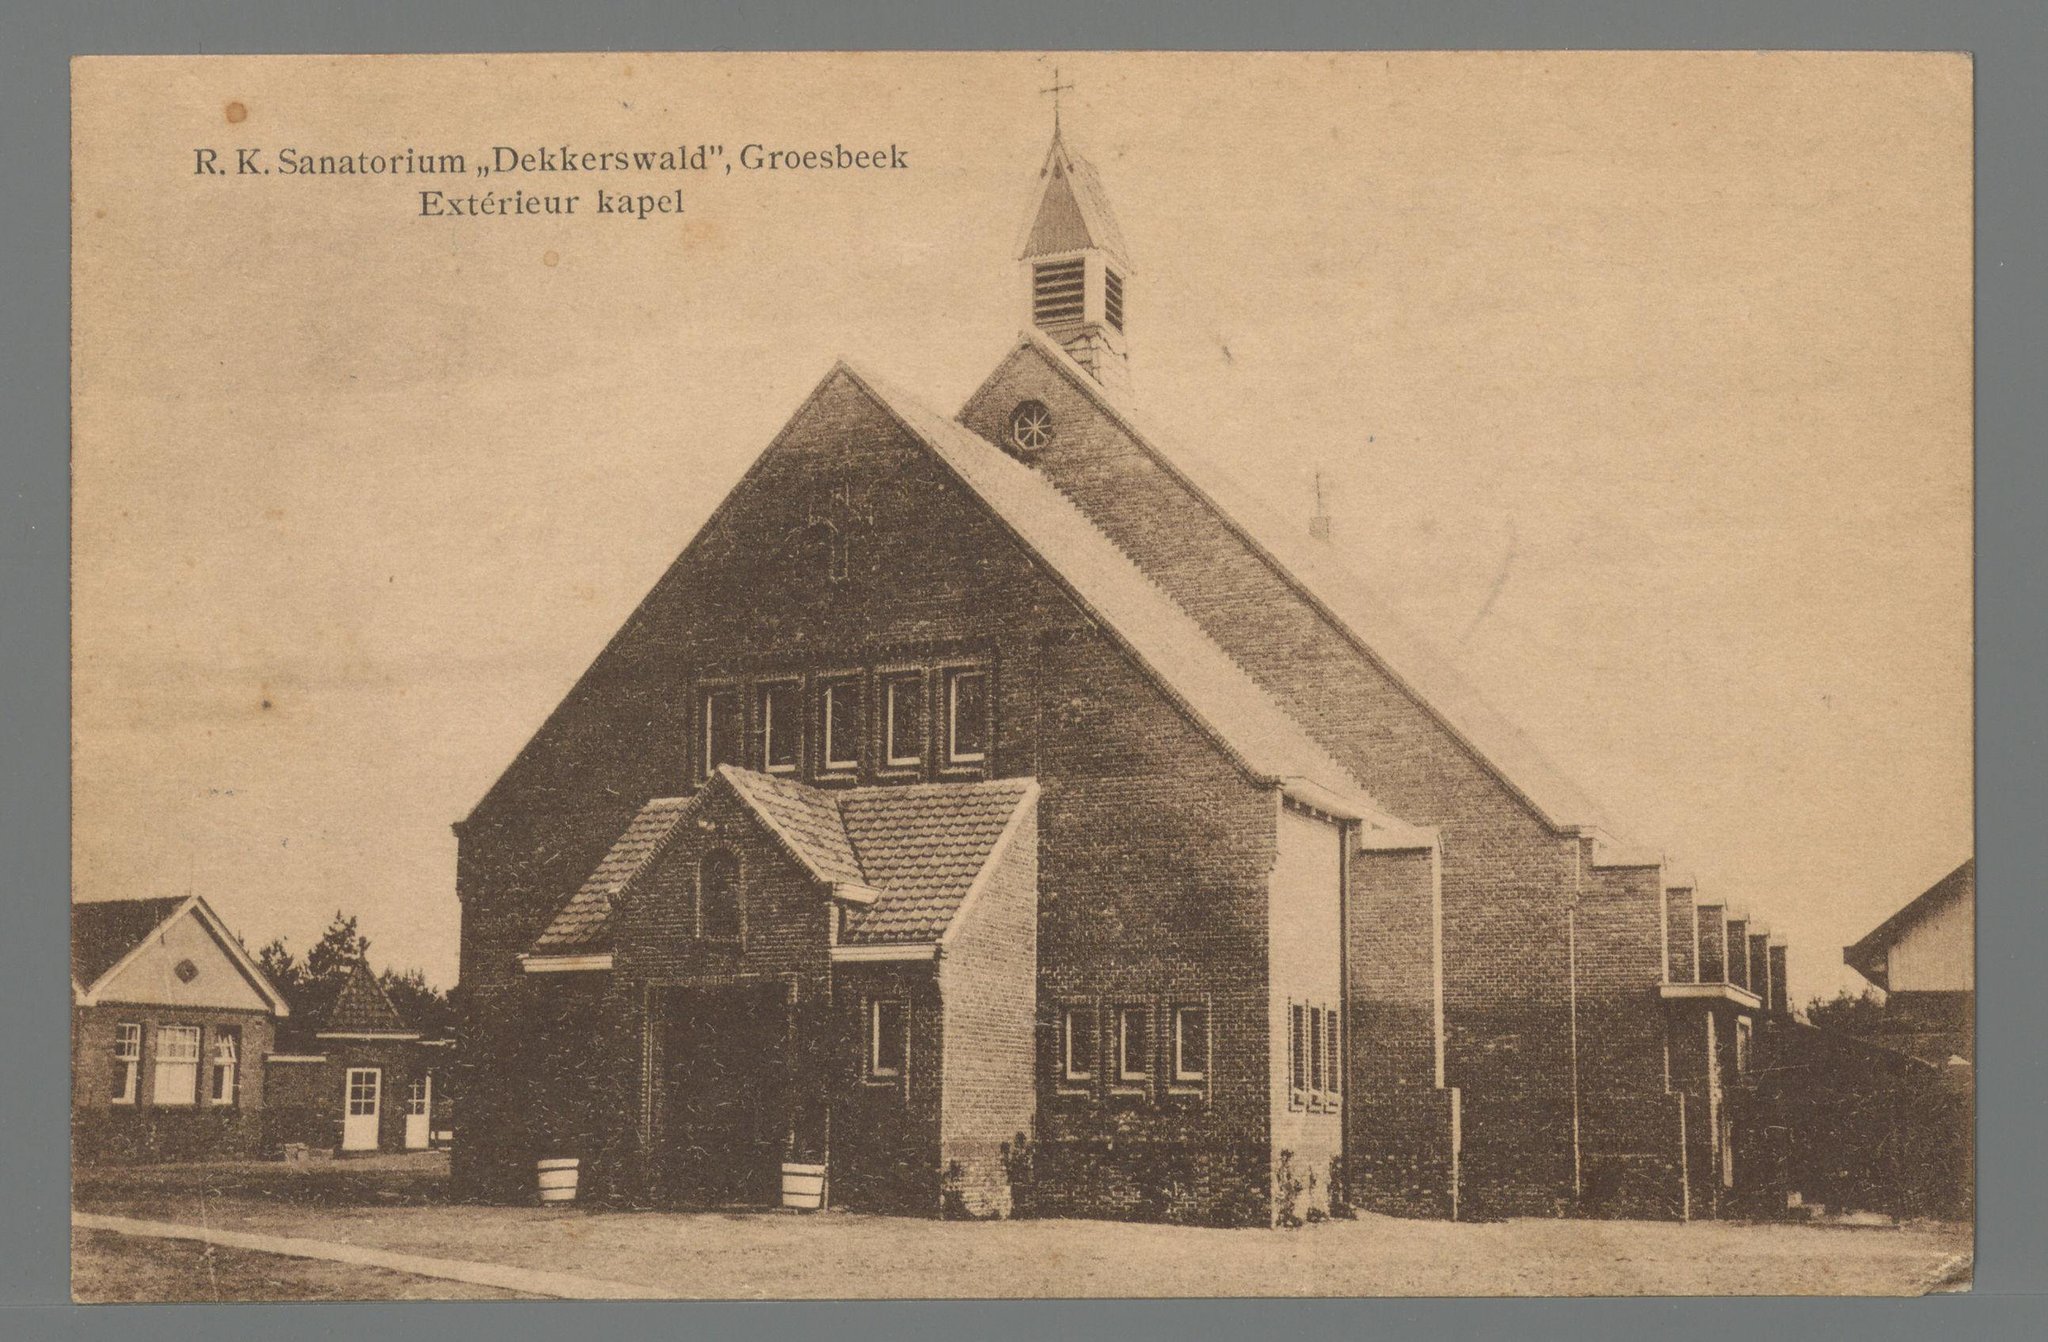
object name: photomechanical print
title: R. K. Sanatorium "Dekkerswald", Groesbeek. Extérieur kapel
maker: Anonymous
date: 1924-1928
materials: cardboard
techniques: photograph, writing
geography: rotterdam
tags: hospital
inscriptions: postage stamp